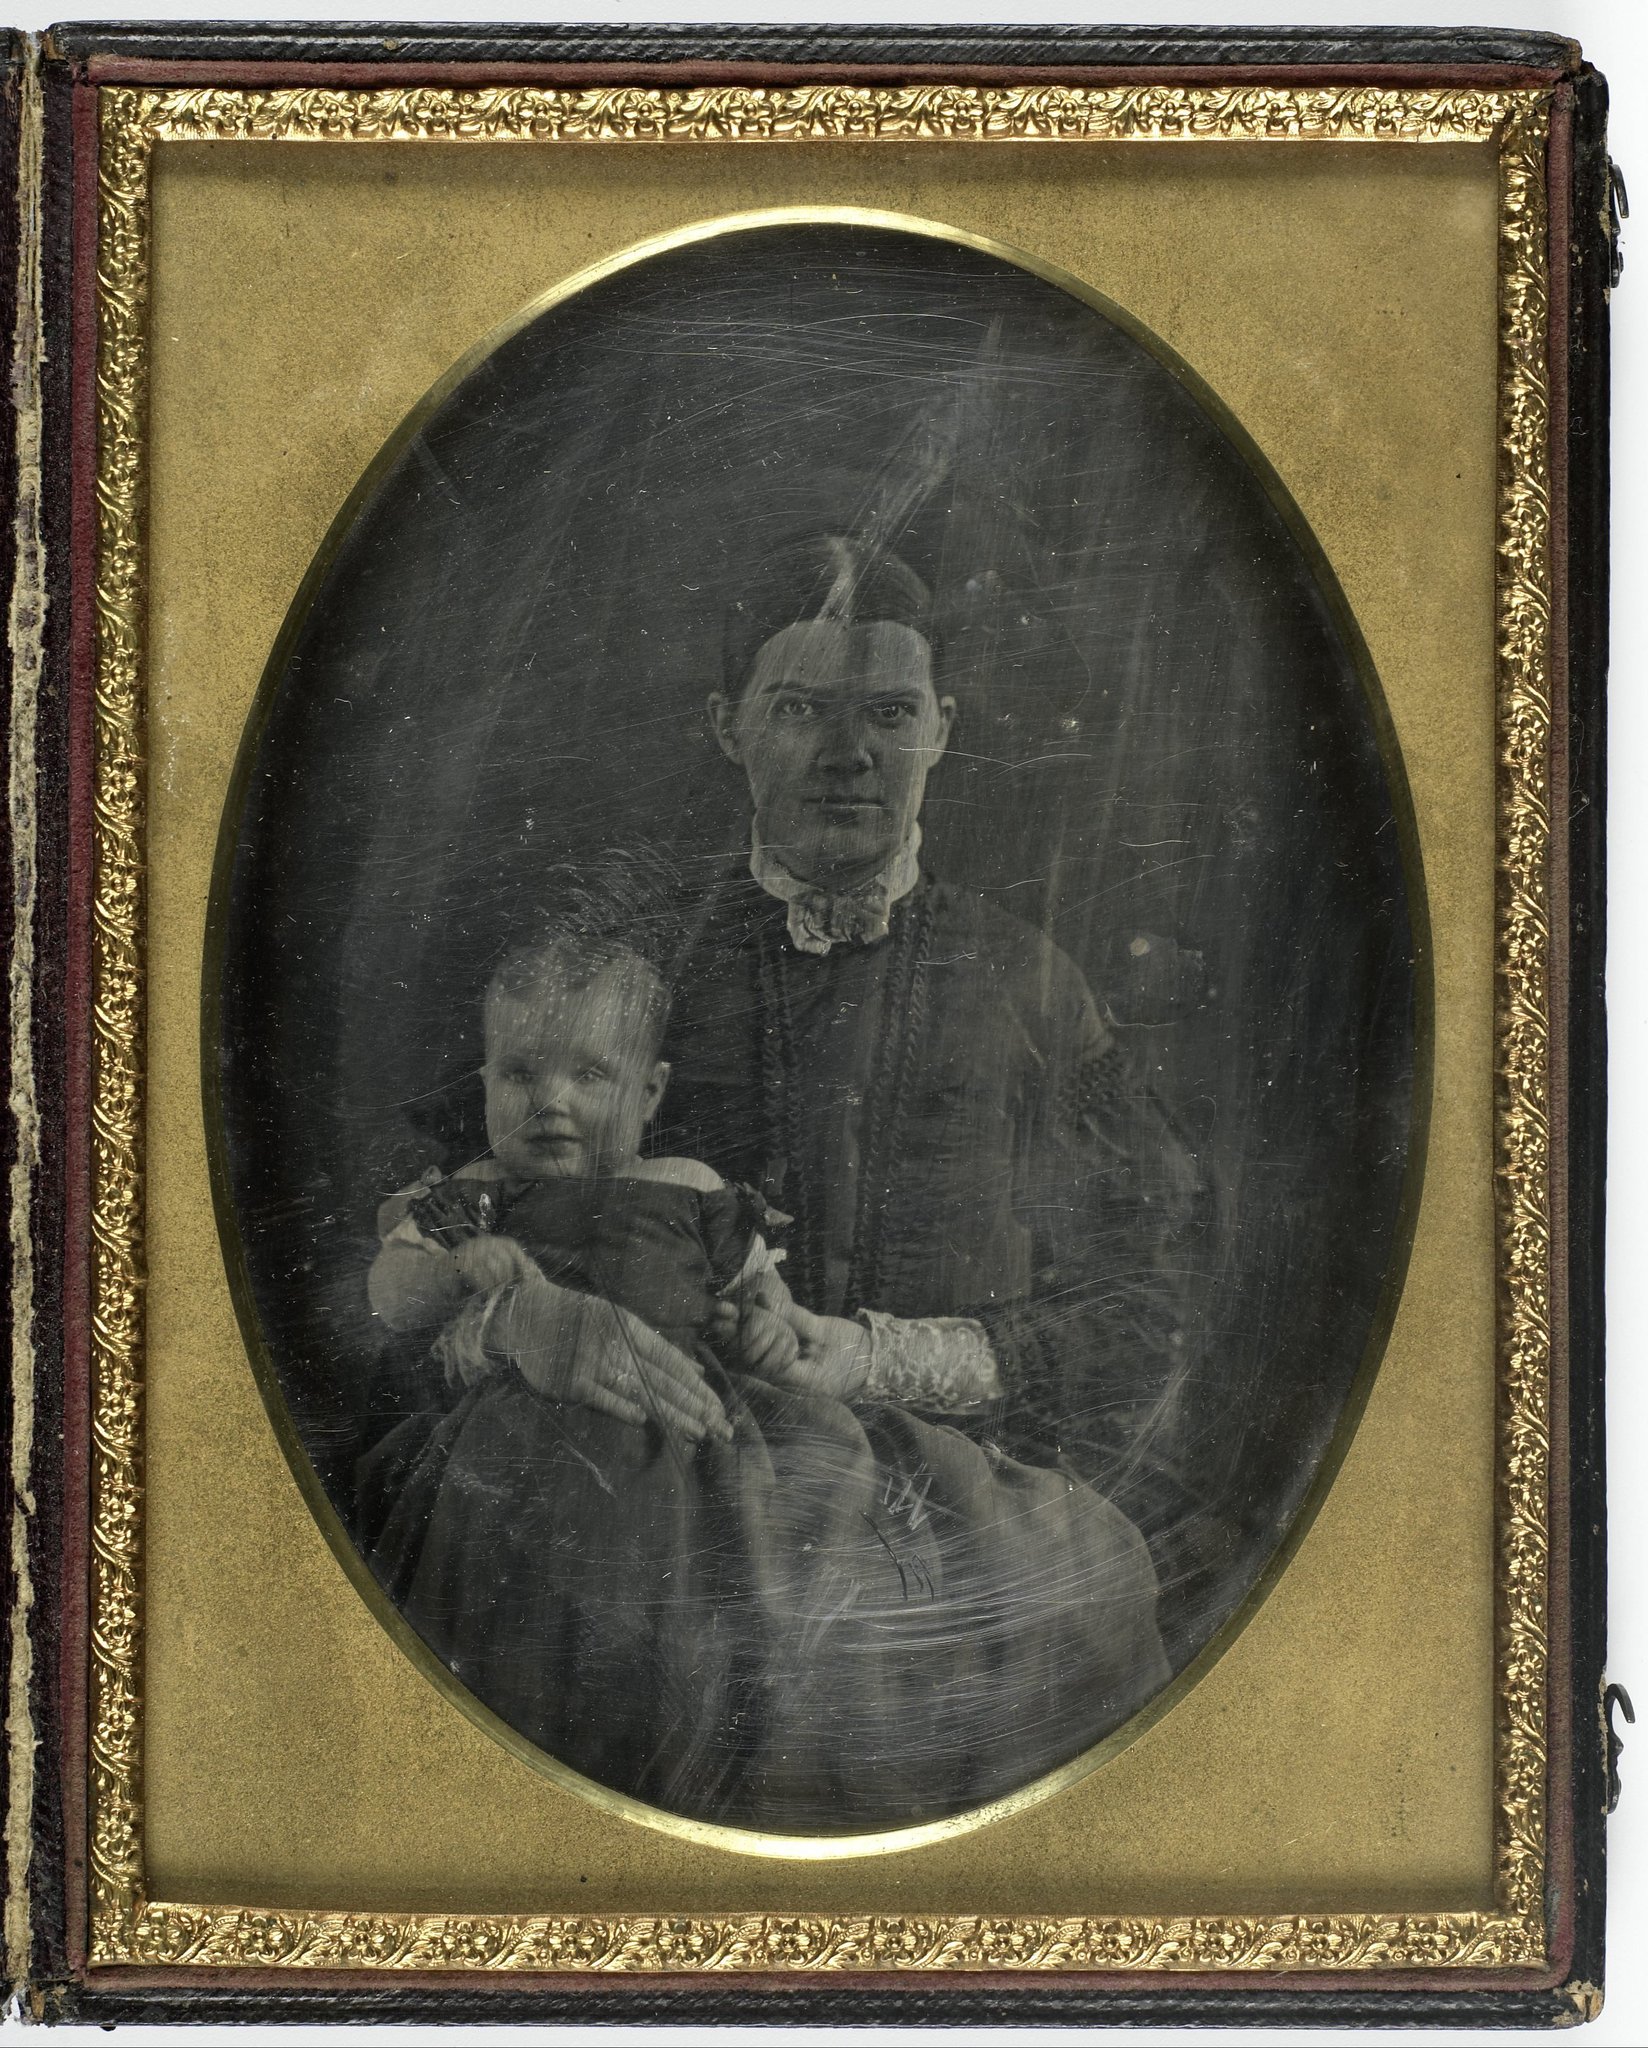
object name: photograph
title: Portret van een onbekende moeder en kind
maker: thomas faris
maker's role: fotograaf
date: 1844-1852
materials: copper, glass, leather, silk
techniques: daguerreotype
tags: historical persons, mother and baby or young child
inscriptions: inscription: ‘T. Faris/ Meodeon Gallery/ Cincinatti’